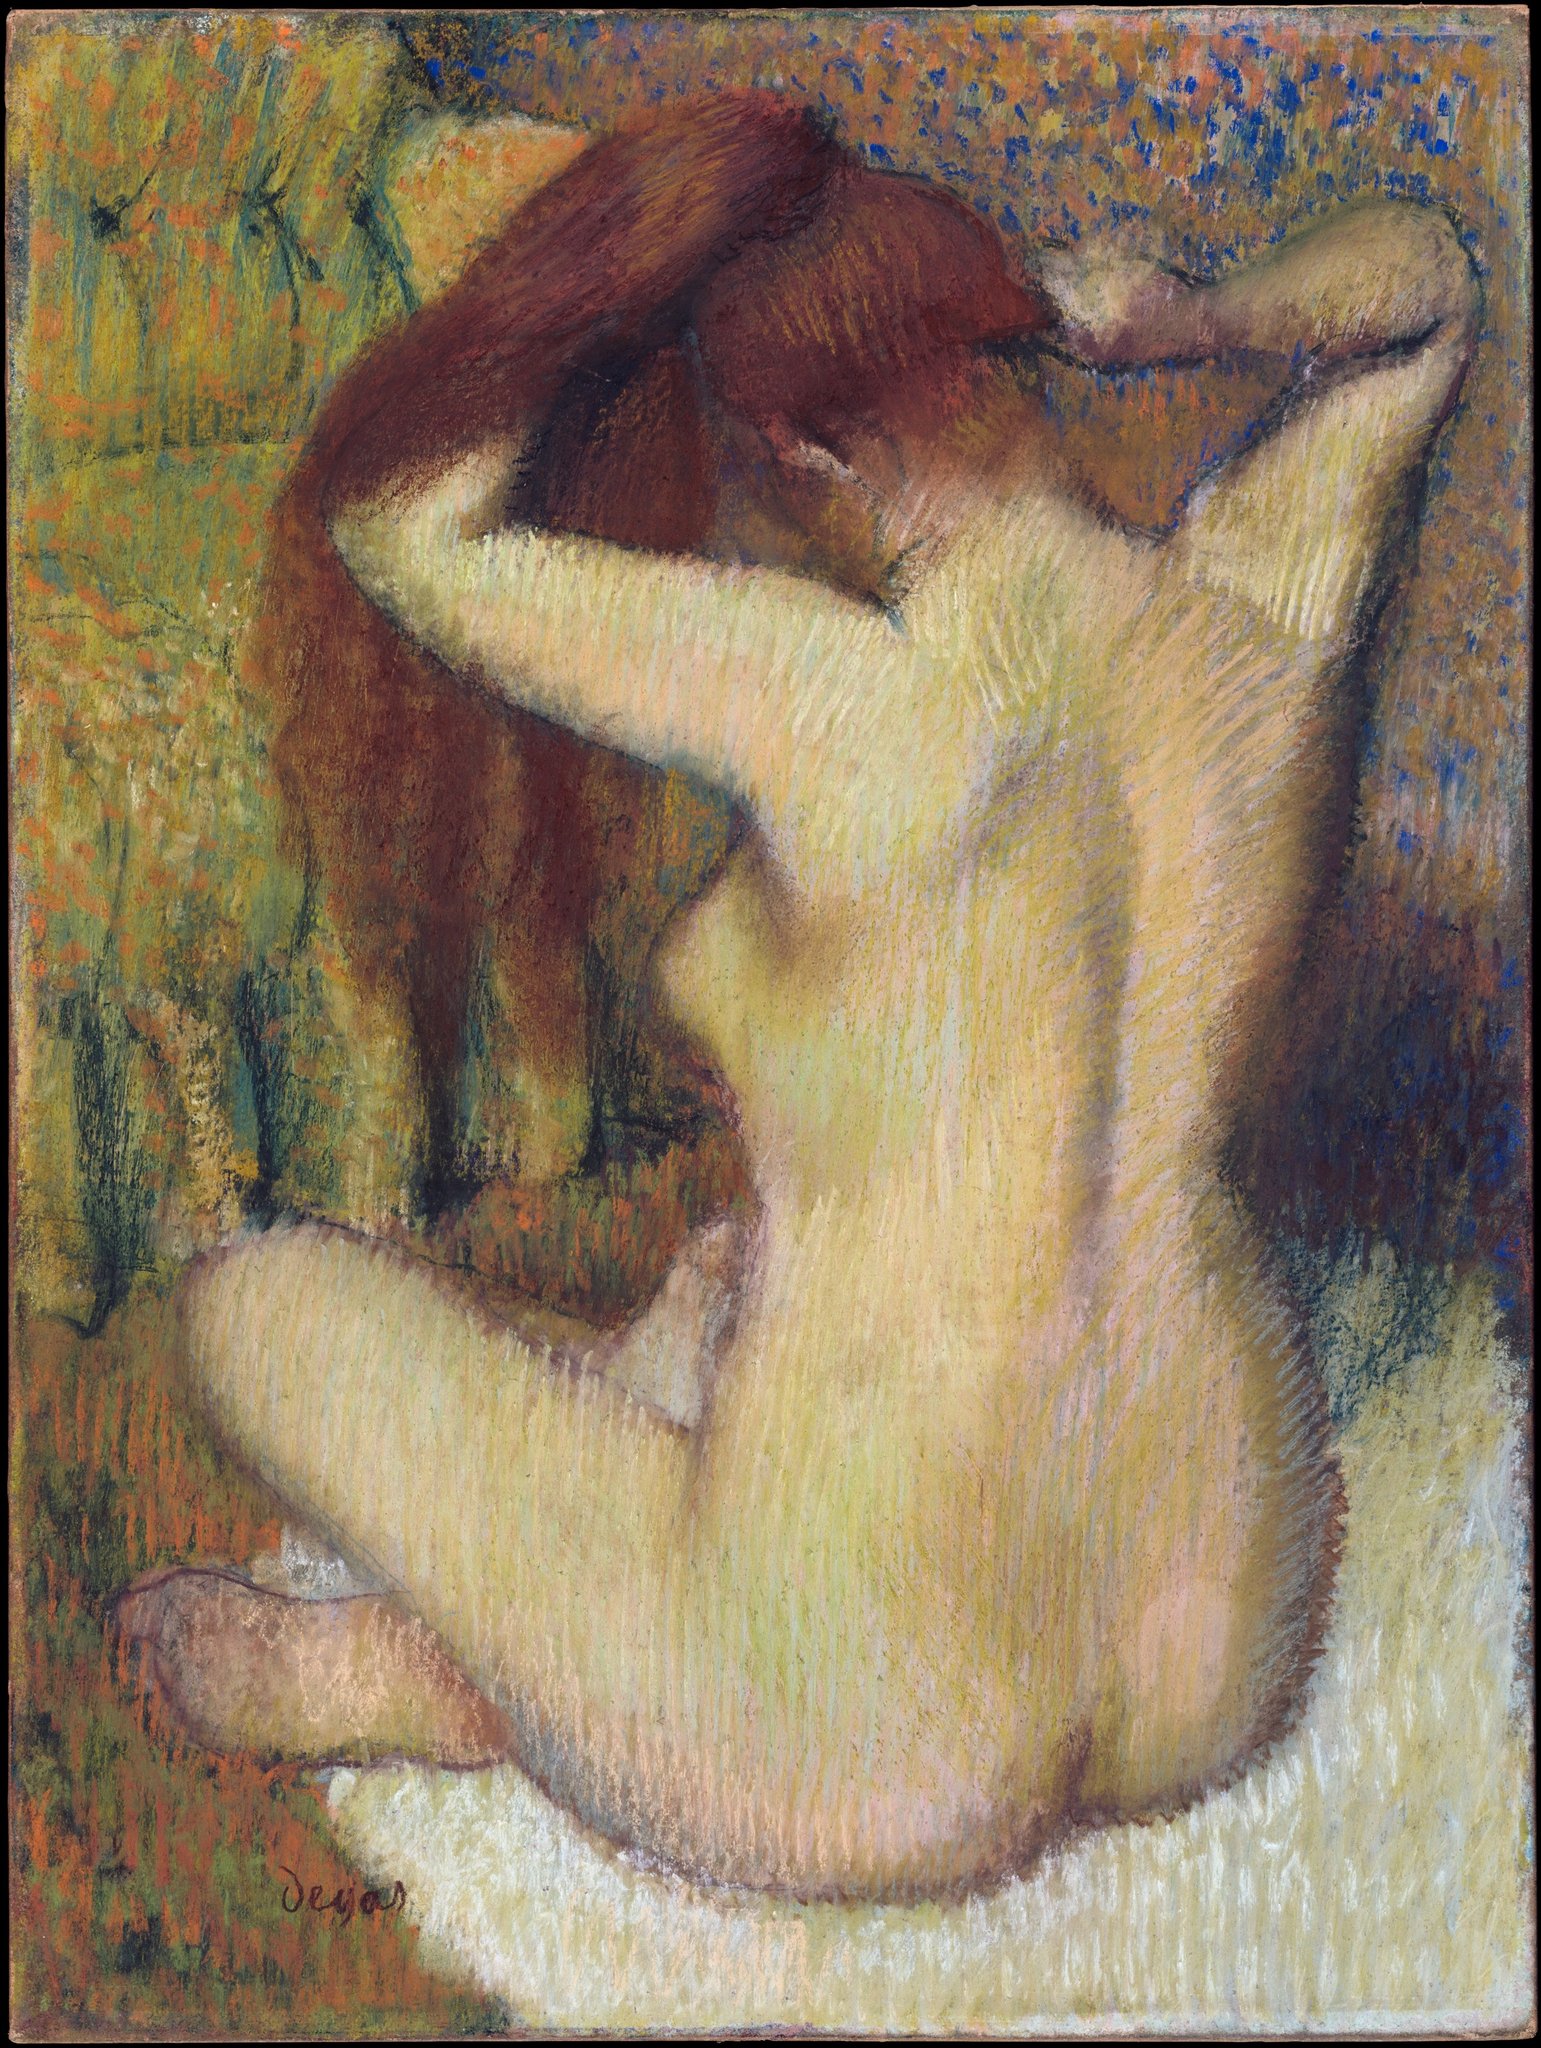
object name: drawing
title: Woman Combing Her Hair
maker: edgar degas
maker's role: artist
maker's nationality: french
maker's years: 1834-1917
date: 1888-1890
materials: pastel, paper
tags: hair,female nudes